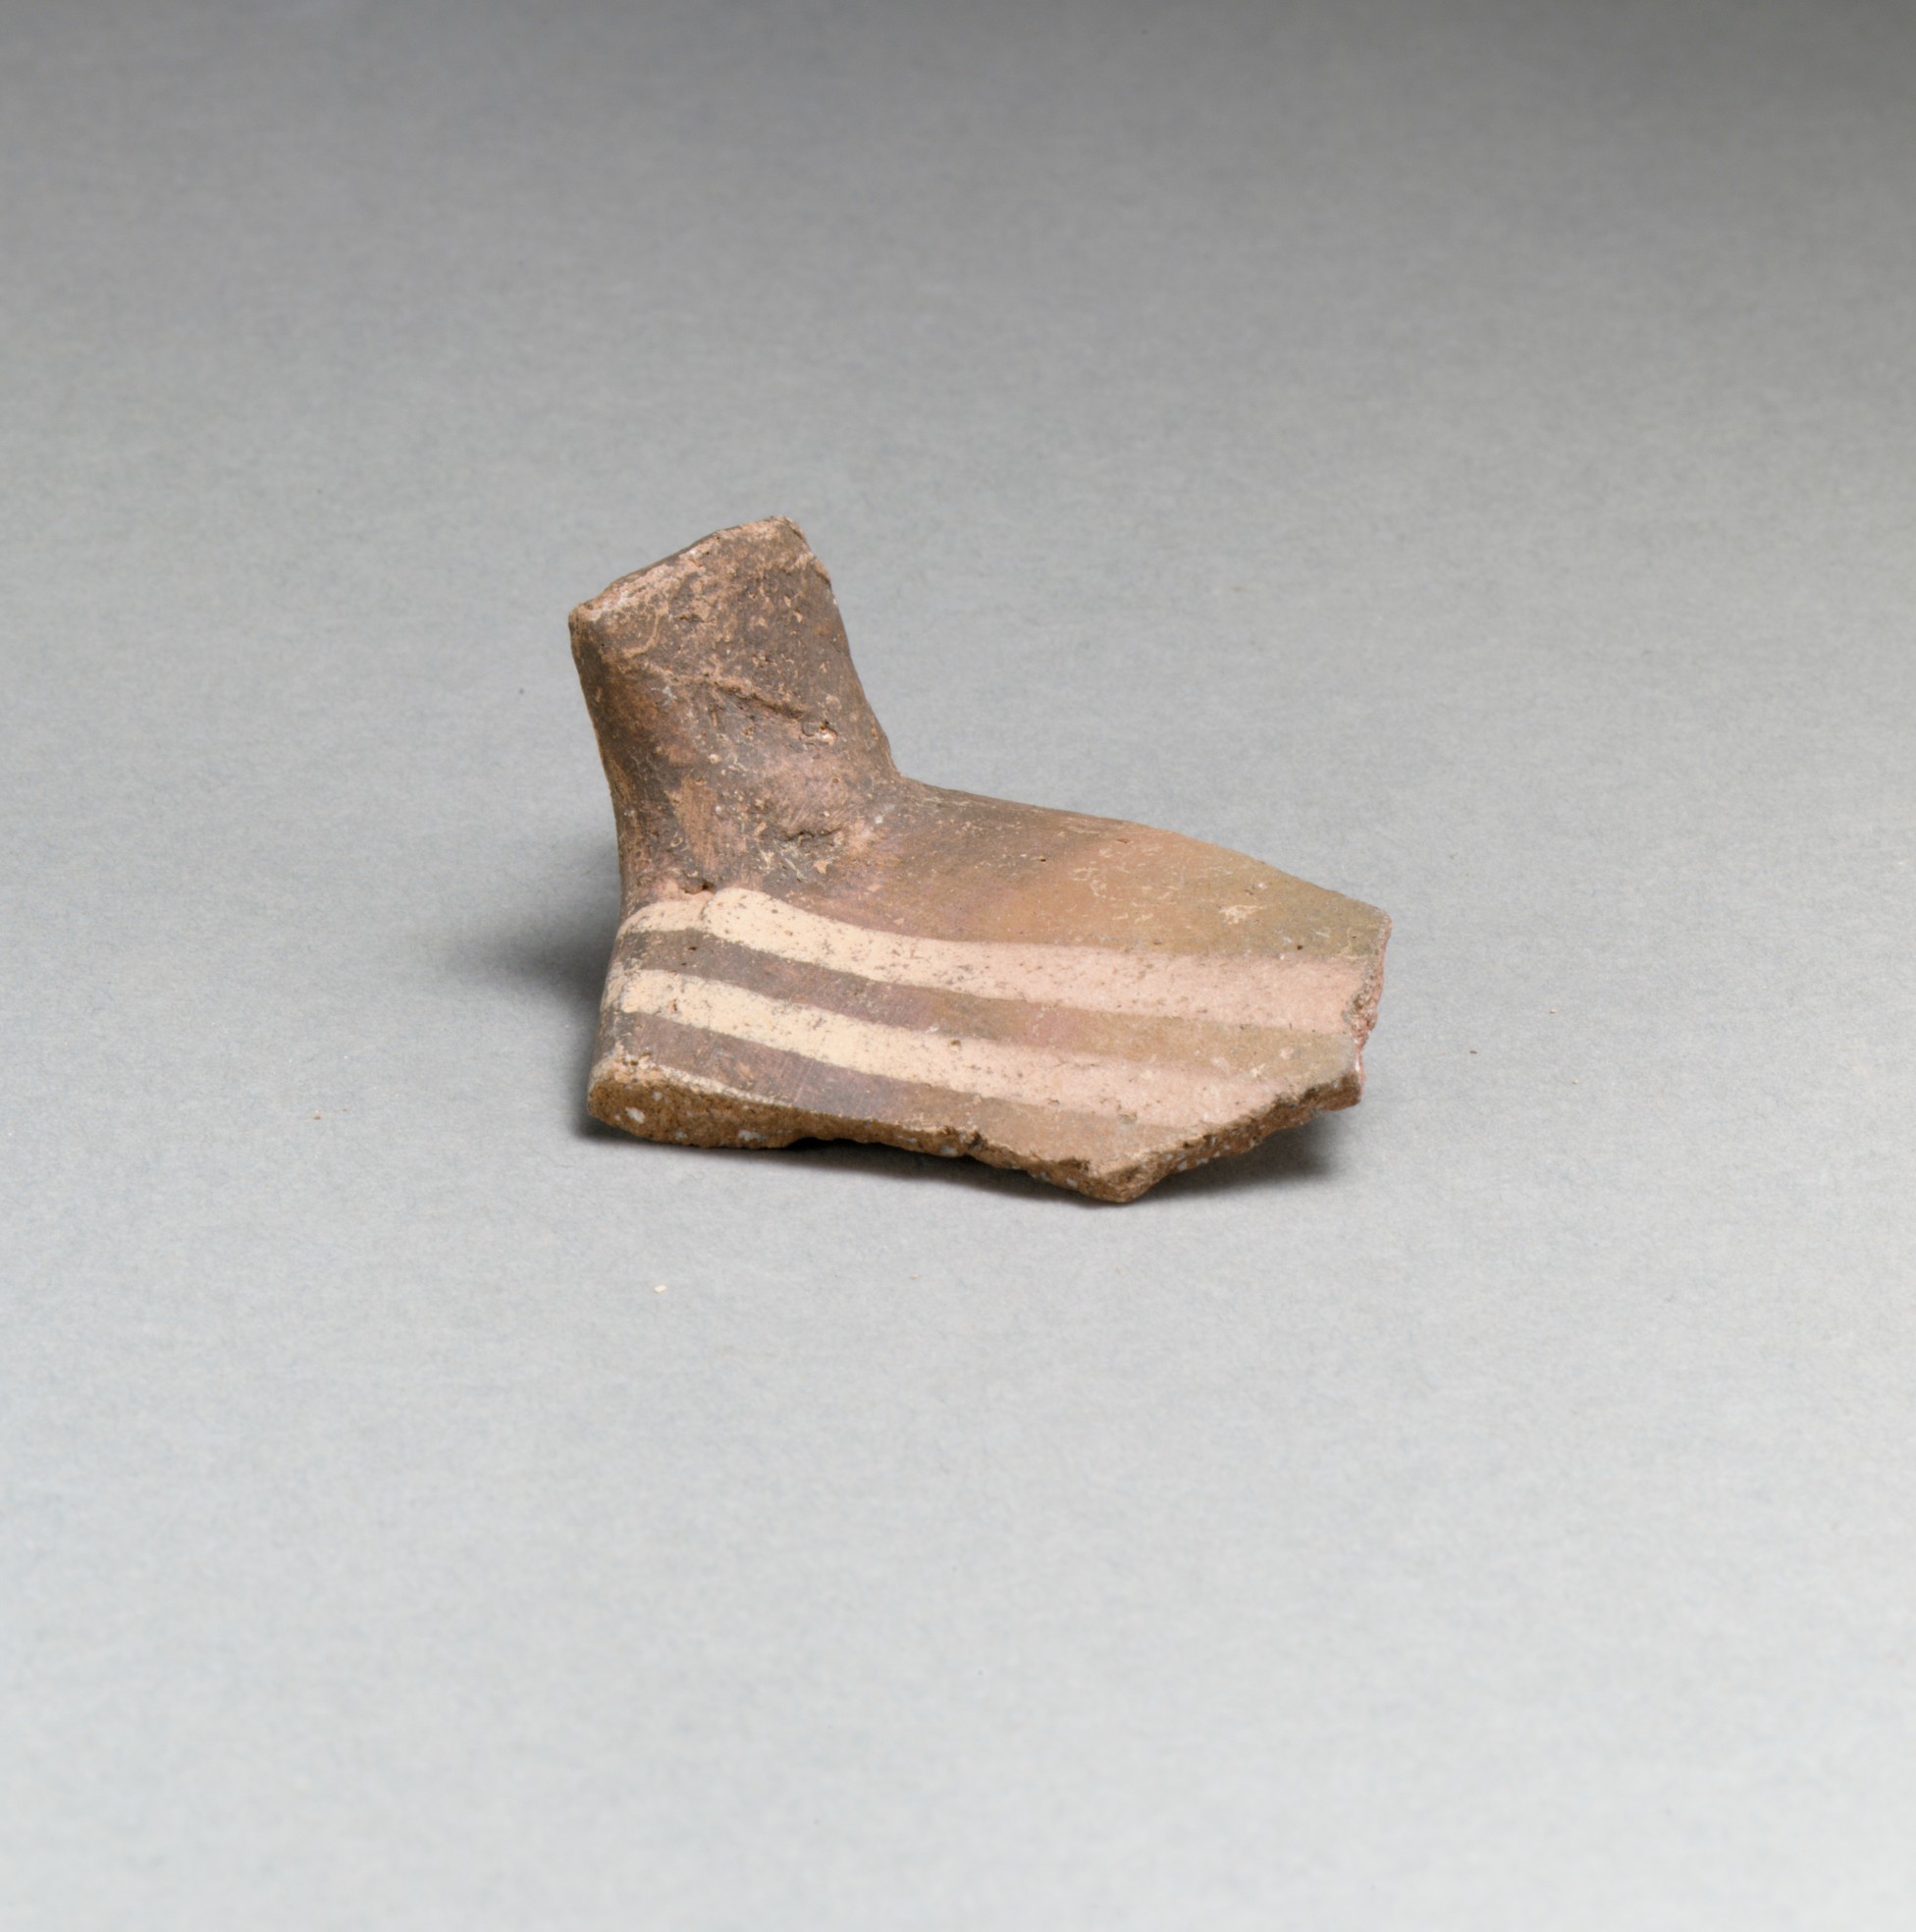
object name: vase fragment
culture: minoan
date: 2600-2000 BCE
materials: terracotta